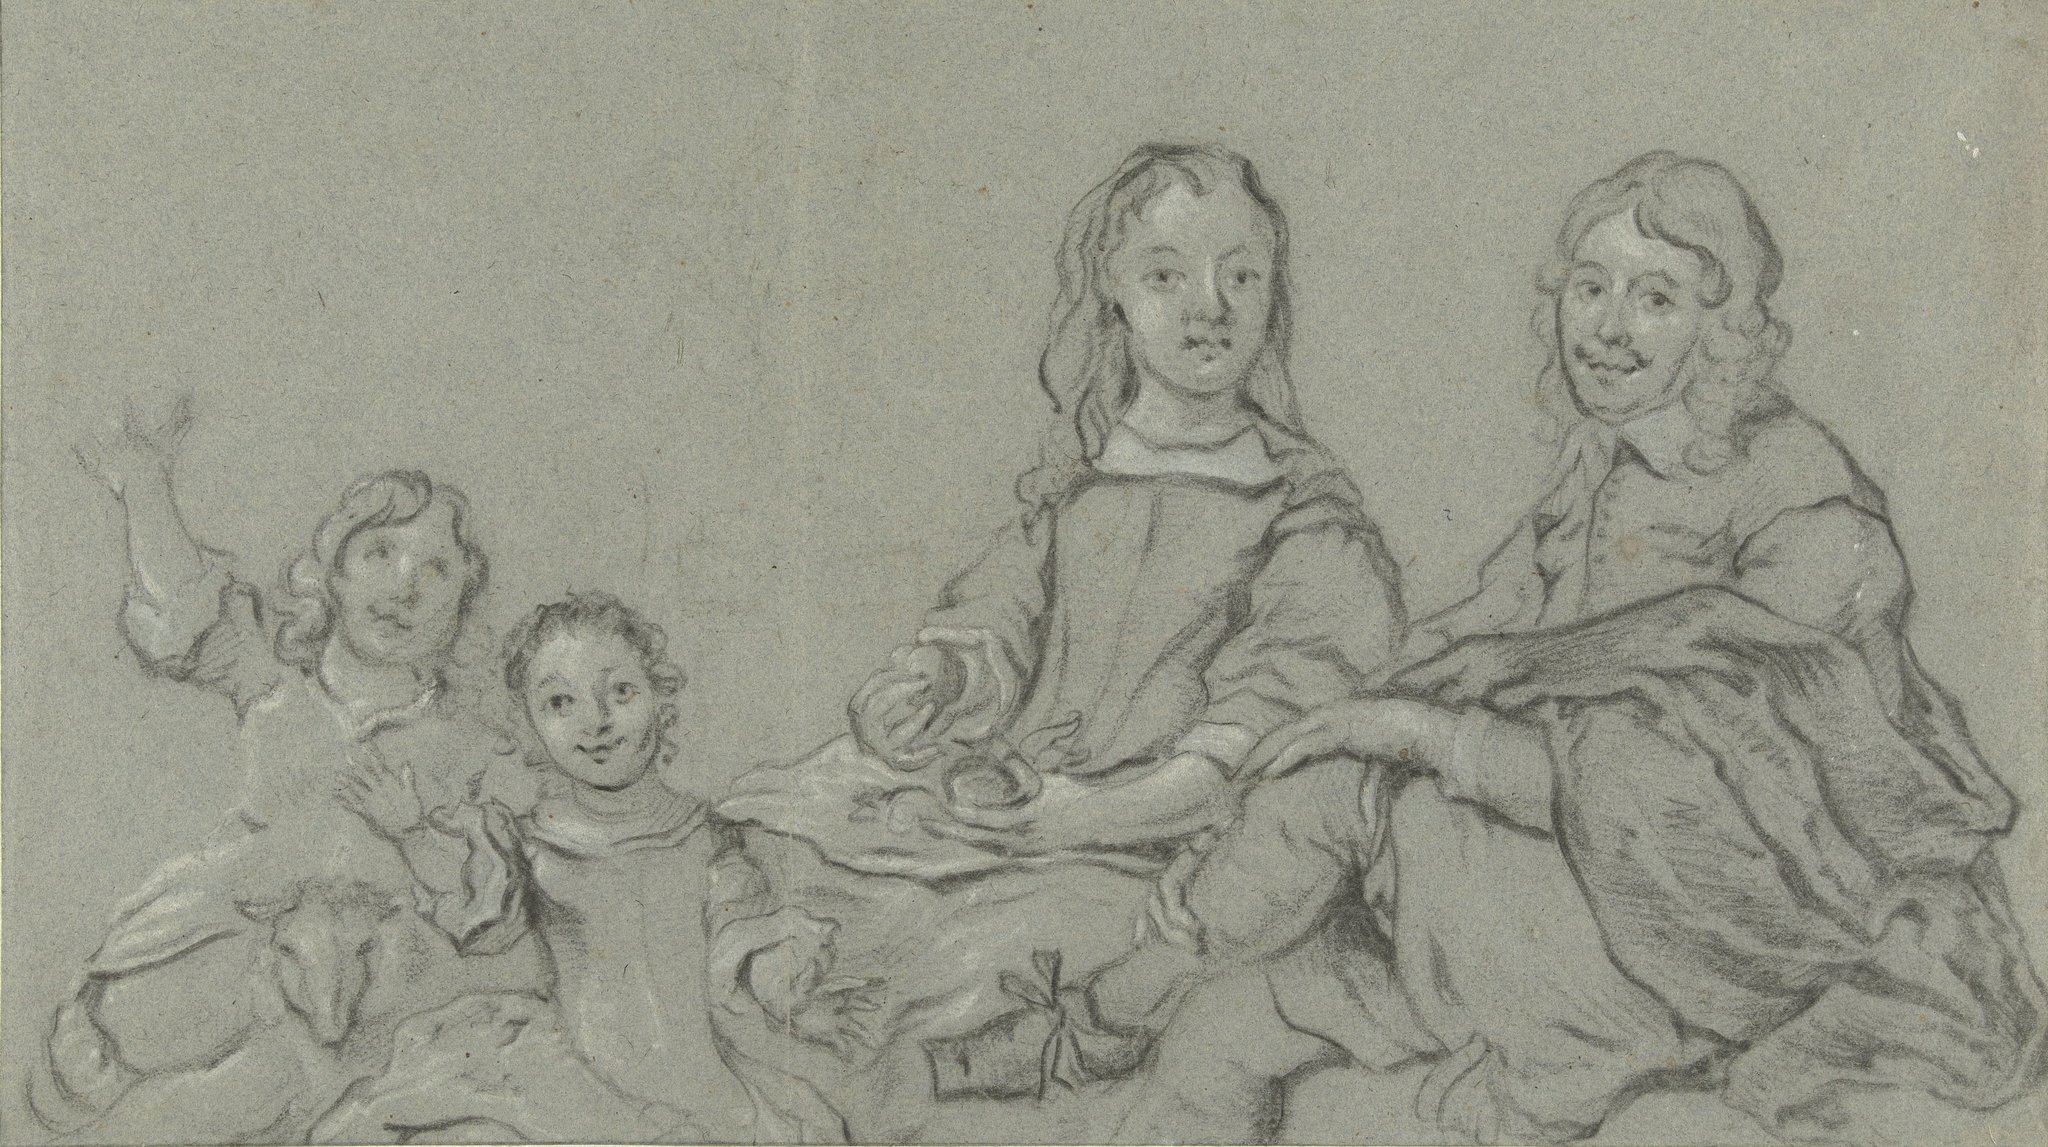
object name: drawing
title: Familiestuk bestaande uit een man, vrouw en twee kinderen met een lam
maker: jan van noordt (1623-1676)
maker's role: draughtsman, painter, print maker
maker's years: 1623-1676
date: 1644-1676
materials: chalk, paper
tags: family group, especially parents with their child(ren) (with number of children)